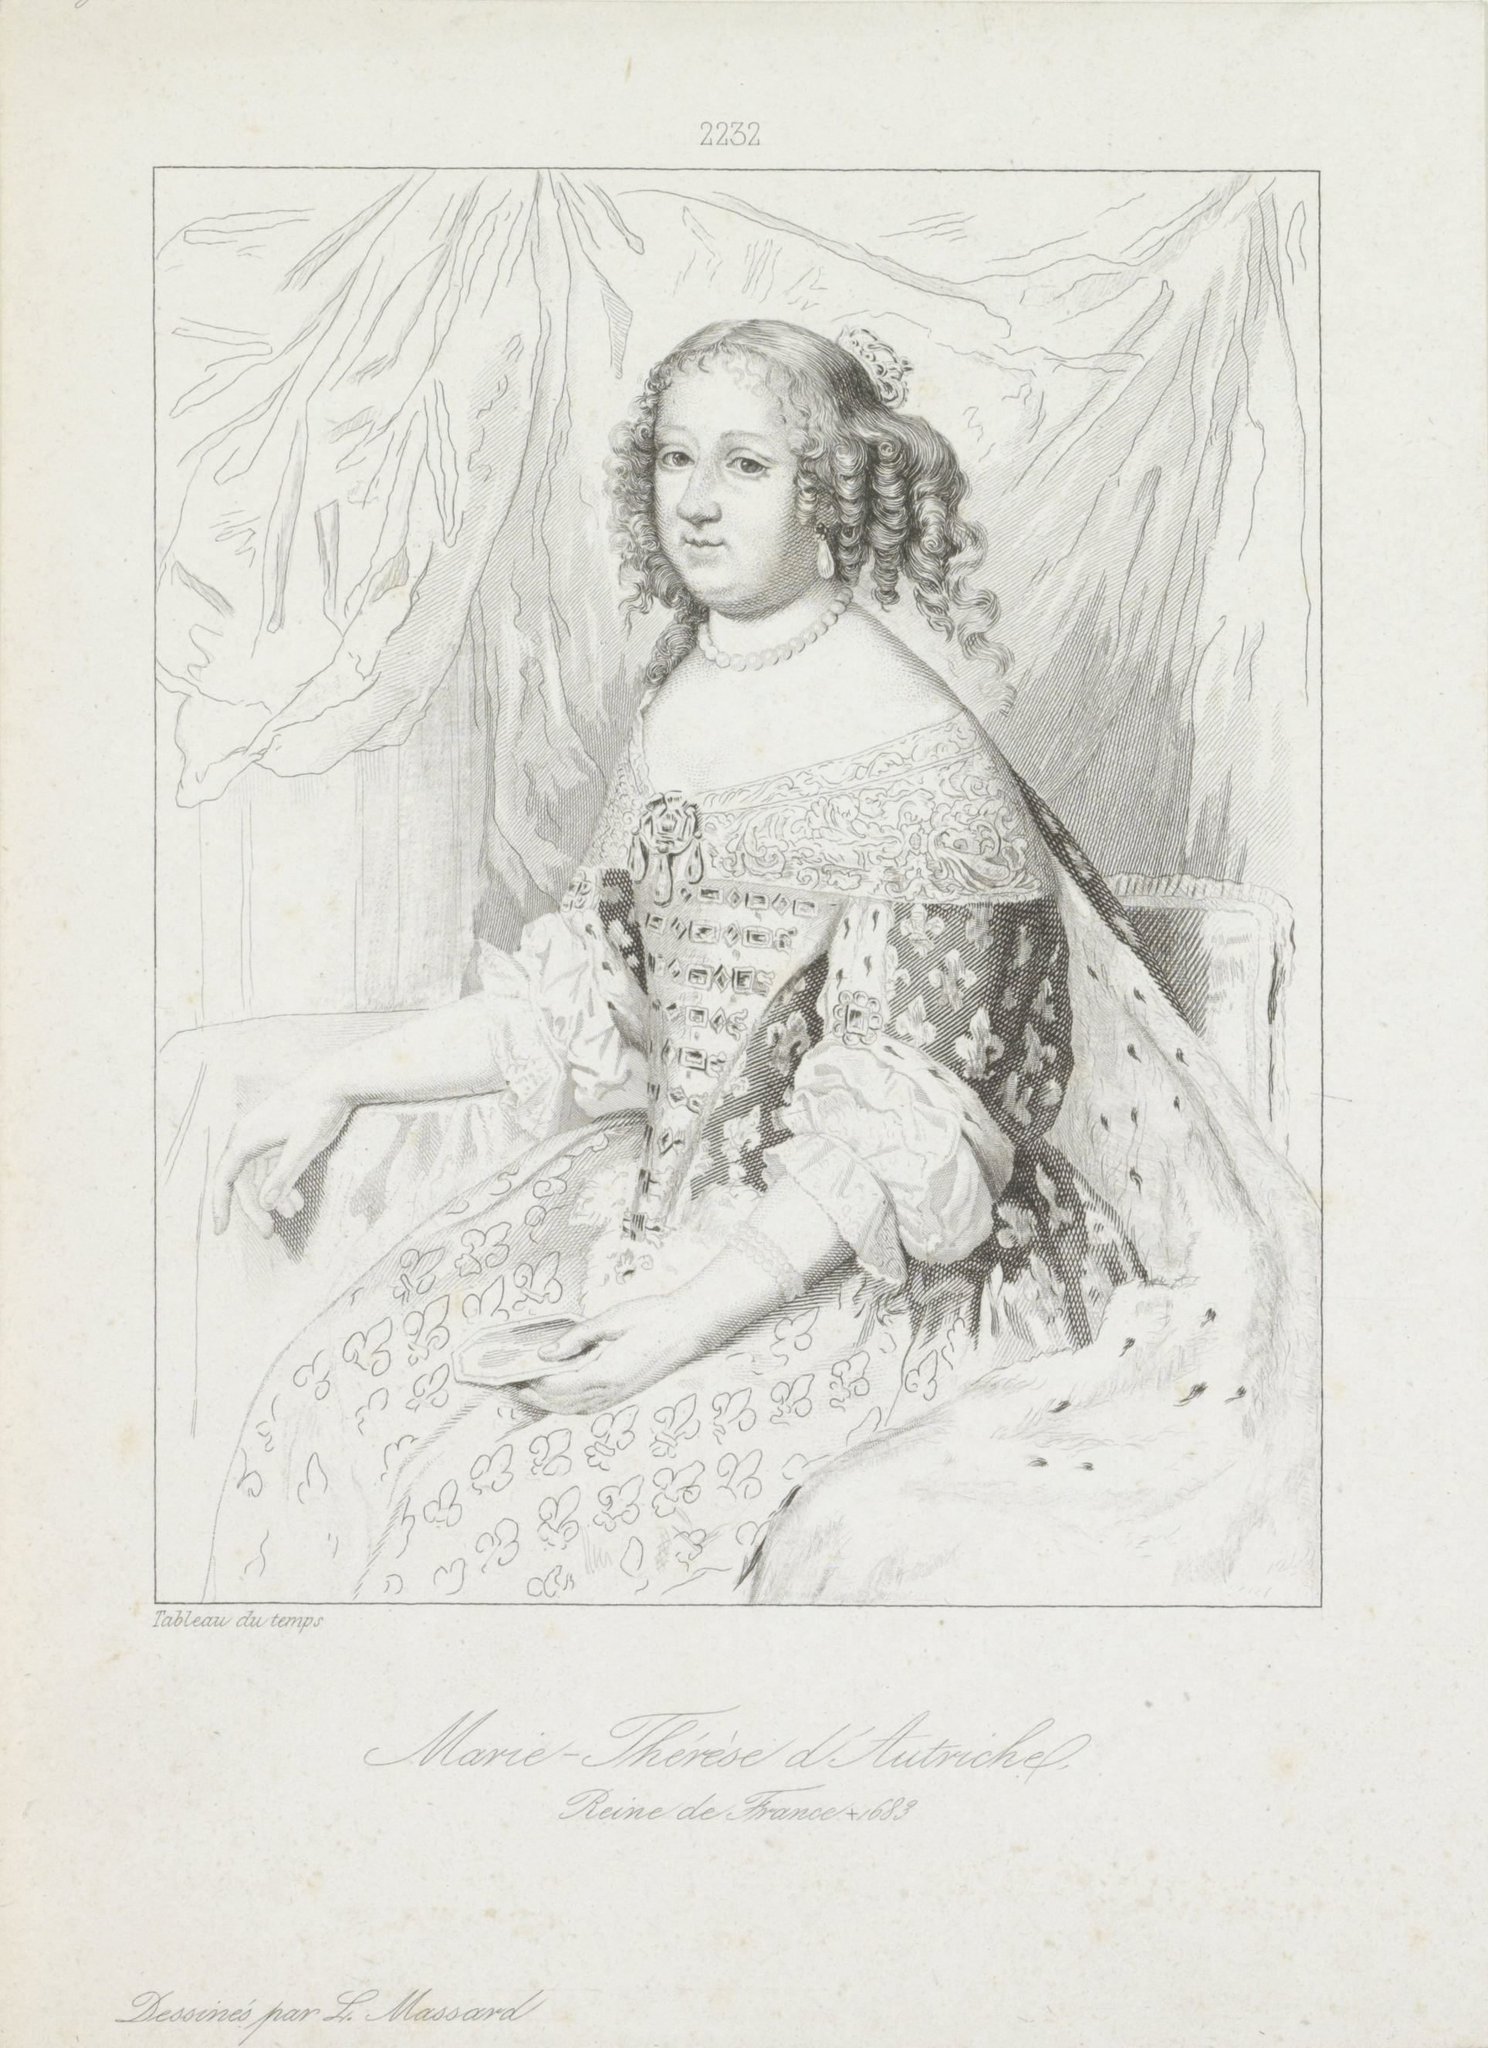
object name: print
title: Galerie historique de Versailles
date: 1818-1848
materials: paper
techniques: engraving, etching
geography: paris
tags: maria theresia (koningin van frankrijk), historical persons, ruler, sovereign - bb - female ruler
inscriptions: collector's mark: Lugt 2228